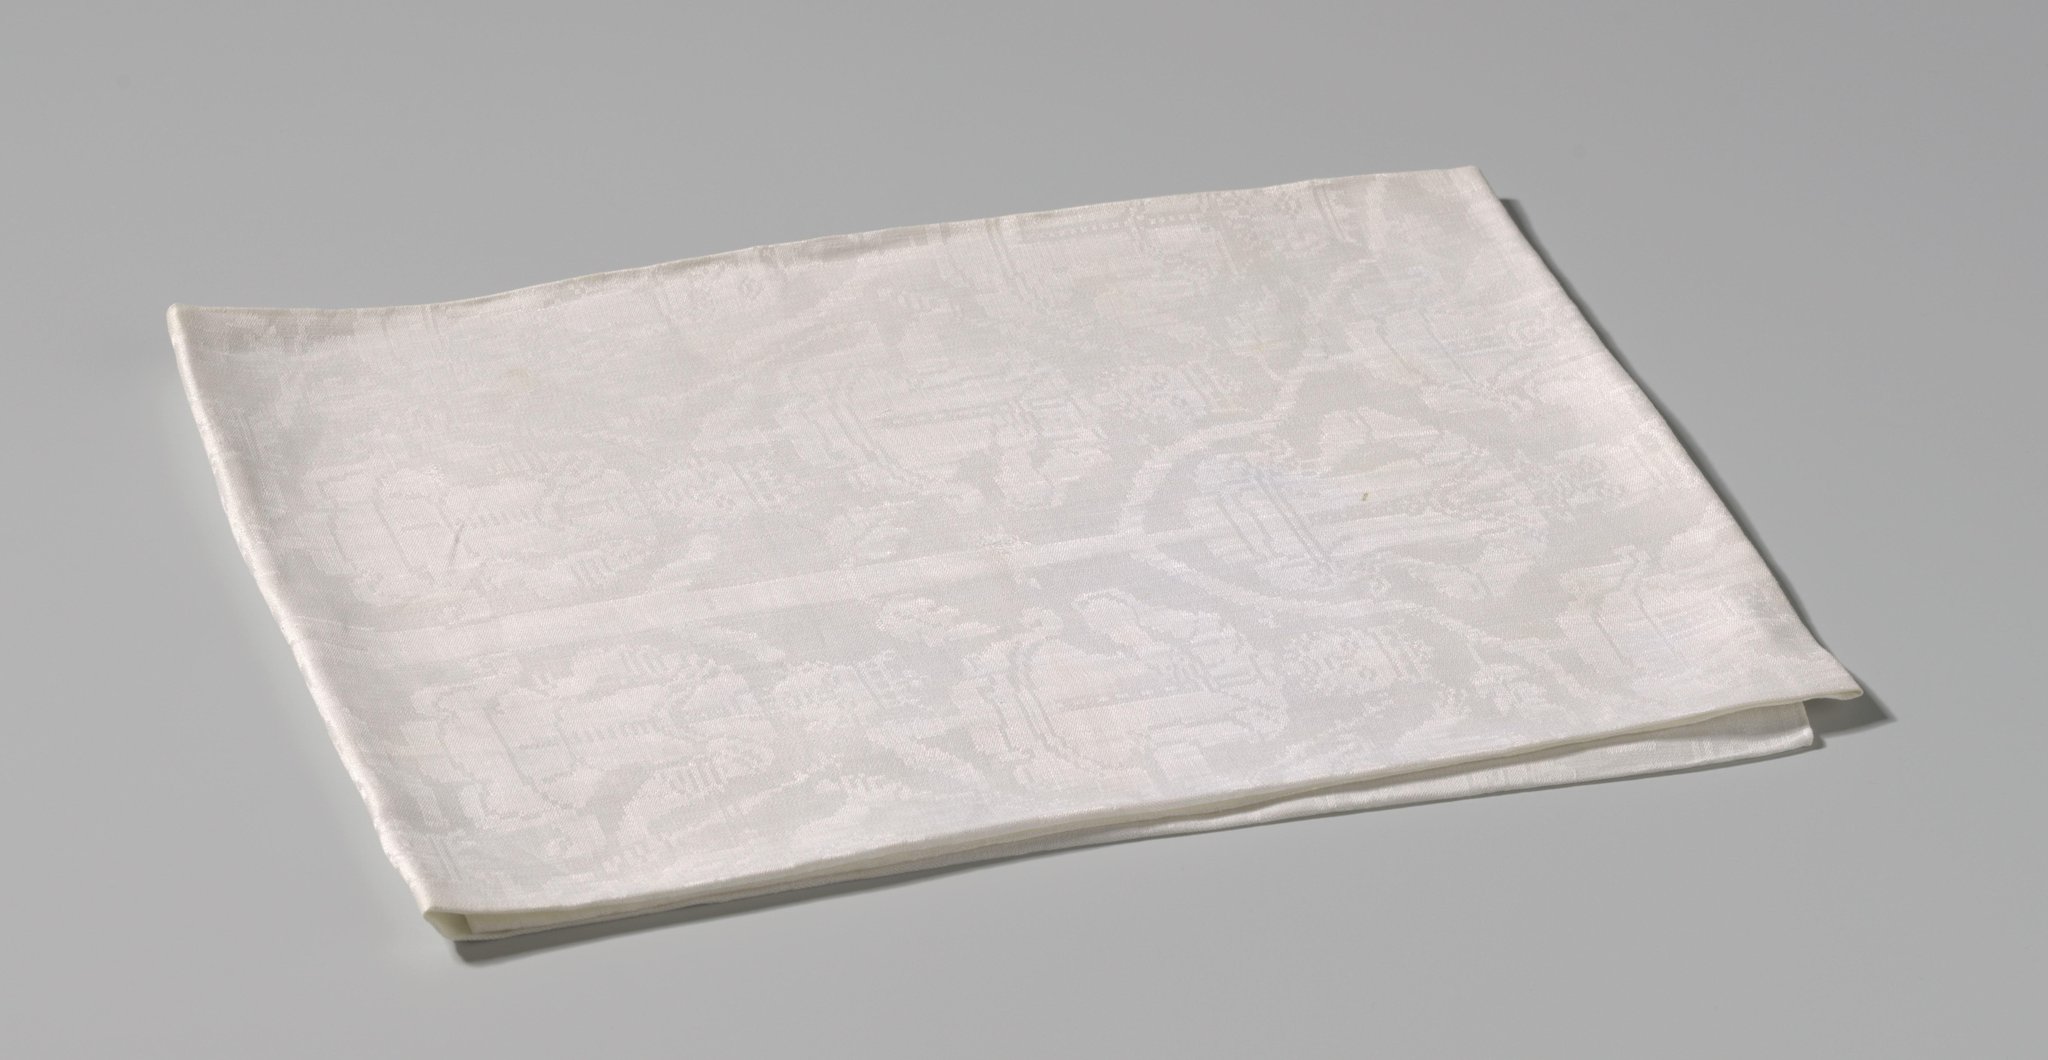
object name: napkin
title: Servet van linnendamast met de boom van Jesse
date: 1600-1625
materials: linen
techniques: damask, weave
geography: netherlands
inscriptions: mark: ‘HK 18’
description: Wit linnendamasten servet met de boom van Jesse. Het servet hoort bij vijf gelijke servetten (BK-1966-145-A t/m BK-1966-145-F).